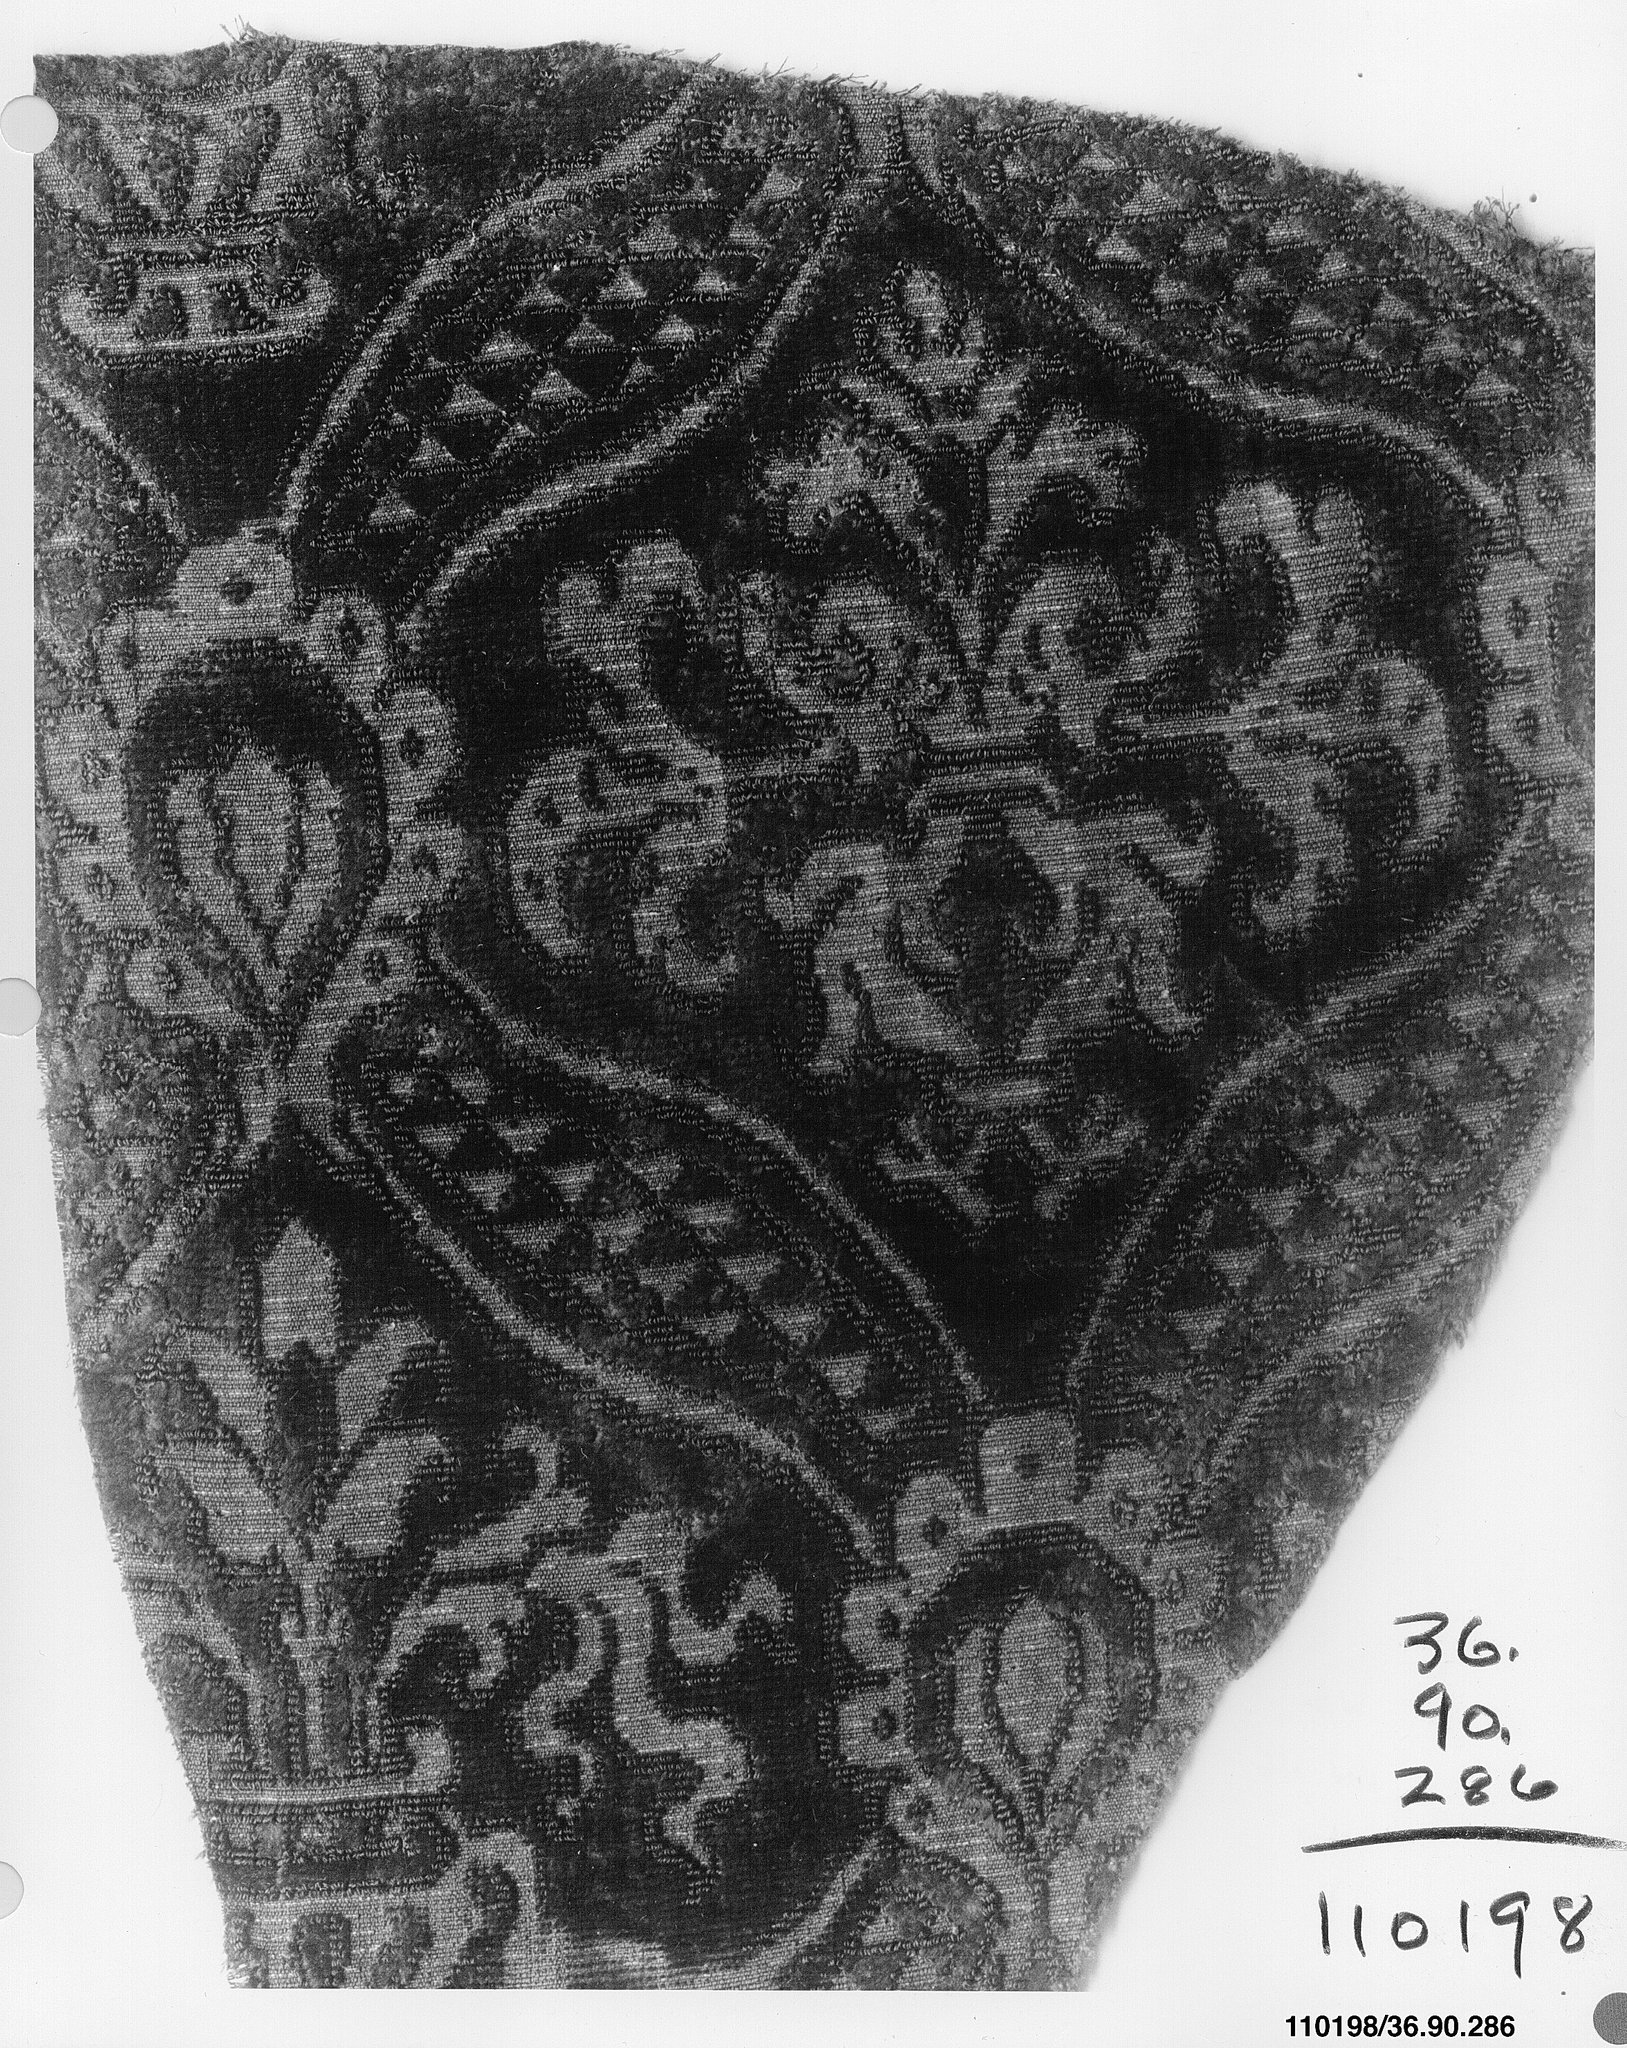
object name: piece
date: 1501-1700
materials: metal thread, silk